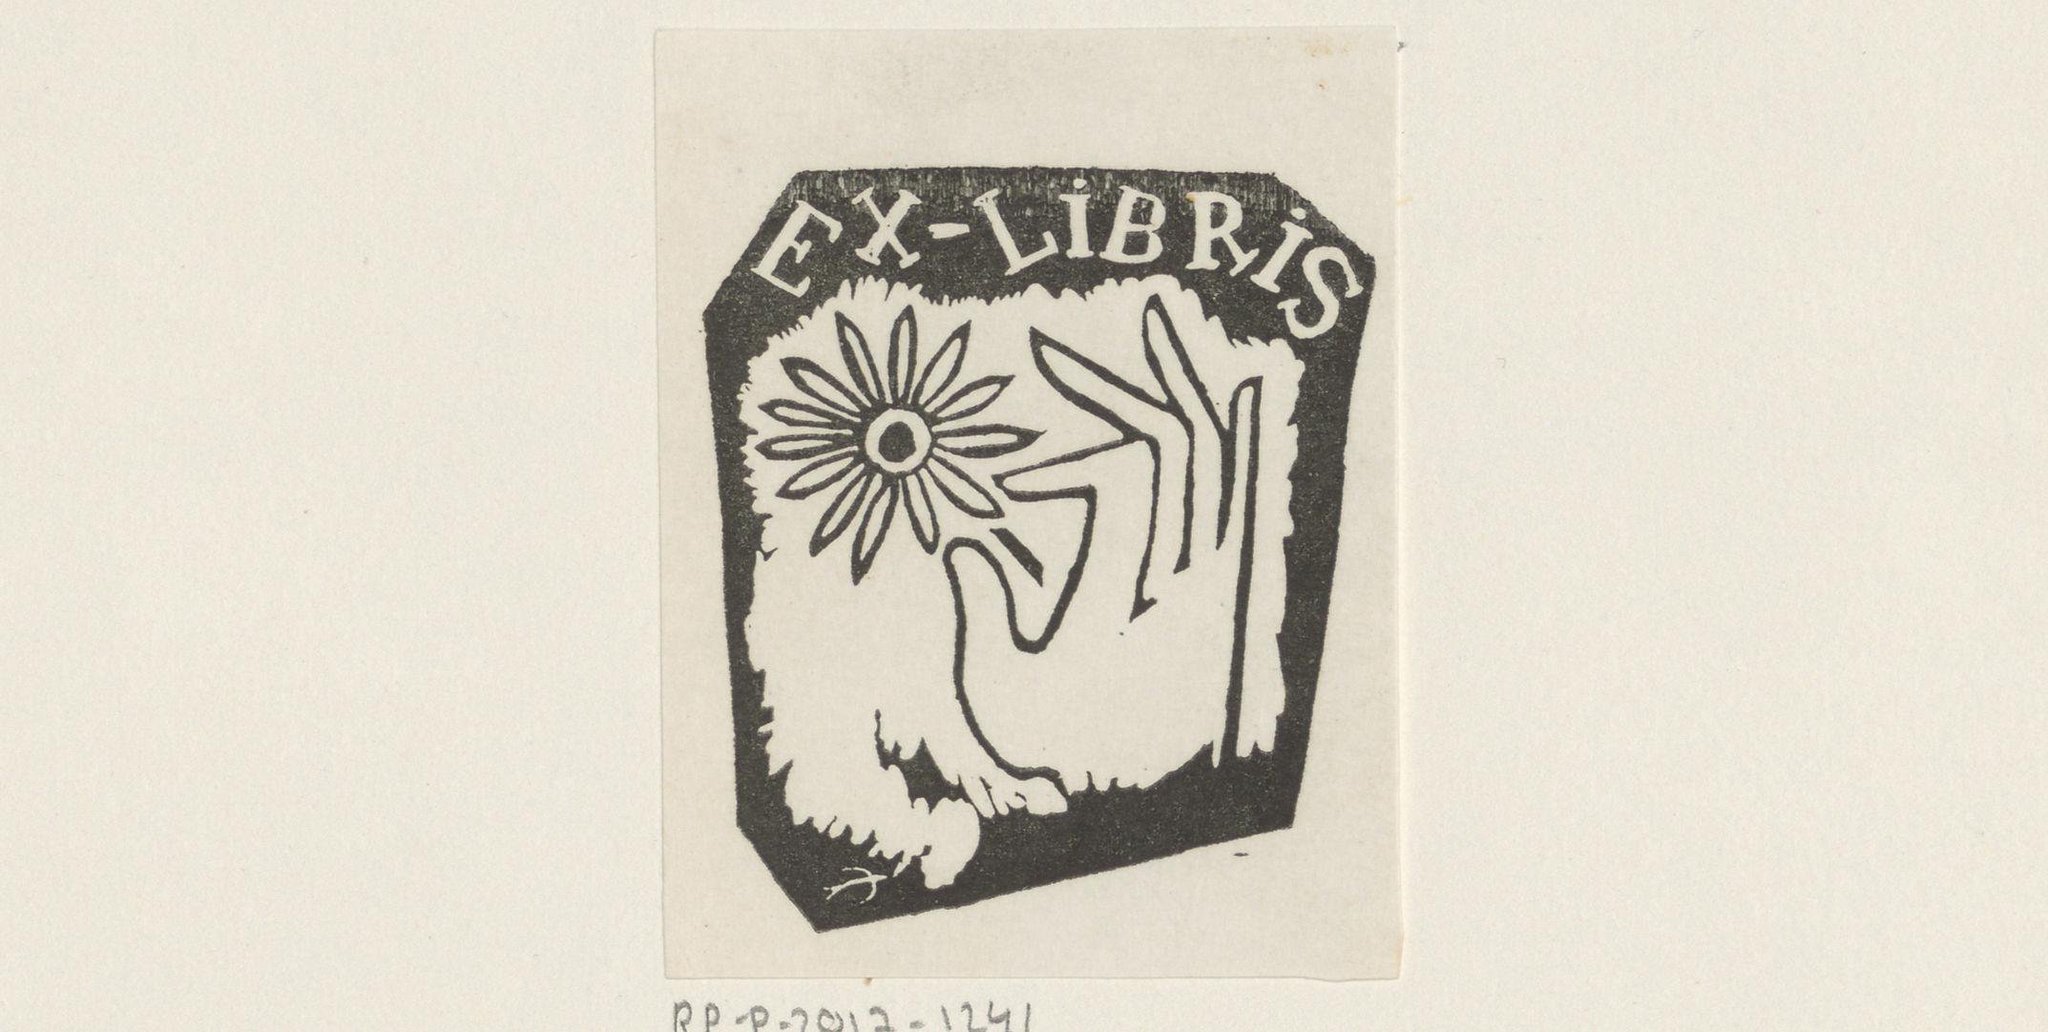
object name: bookplate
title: Ex libris van onbekend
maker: Anonymous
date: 1900-1999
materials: paper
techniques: woodcut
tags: picking flowers, flowers, imposition of hands